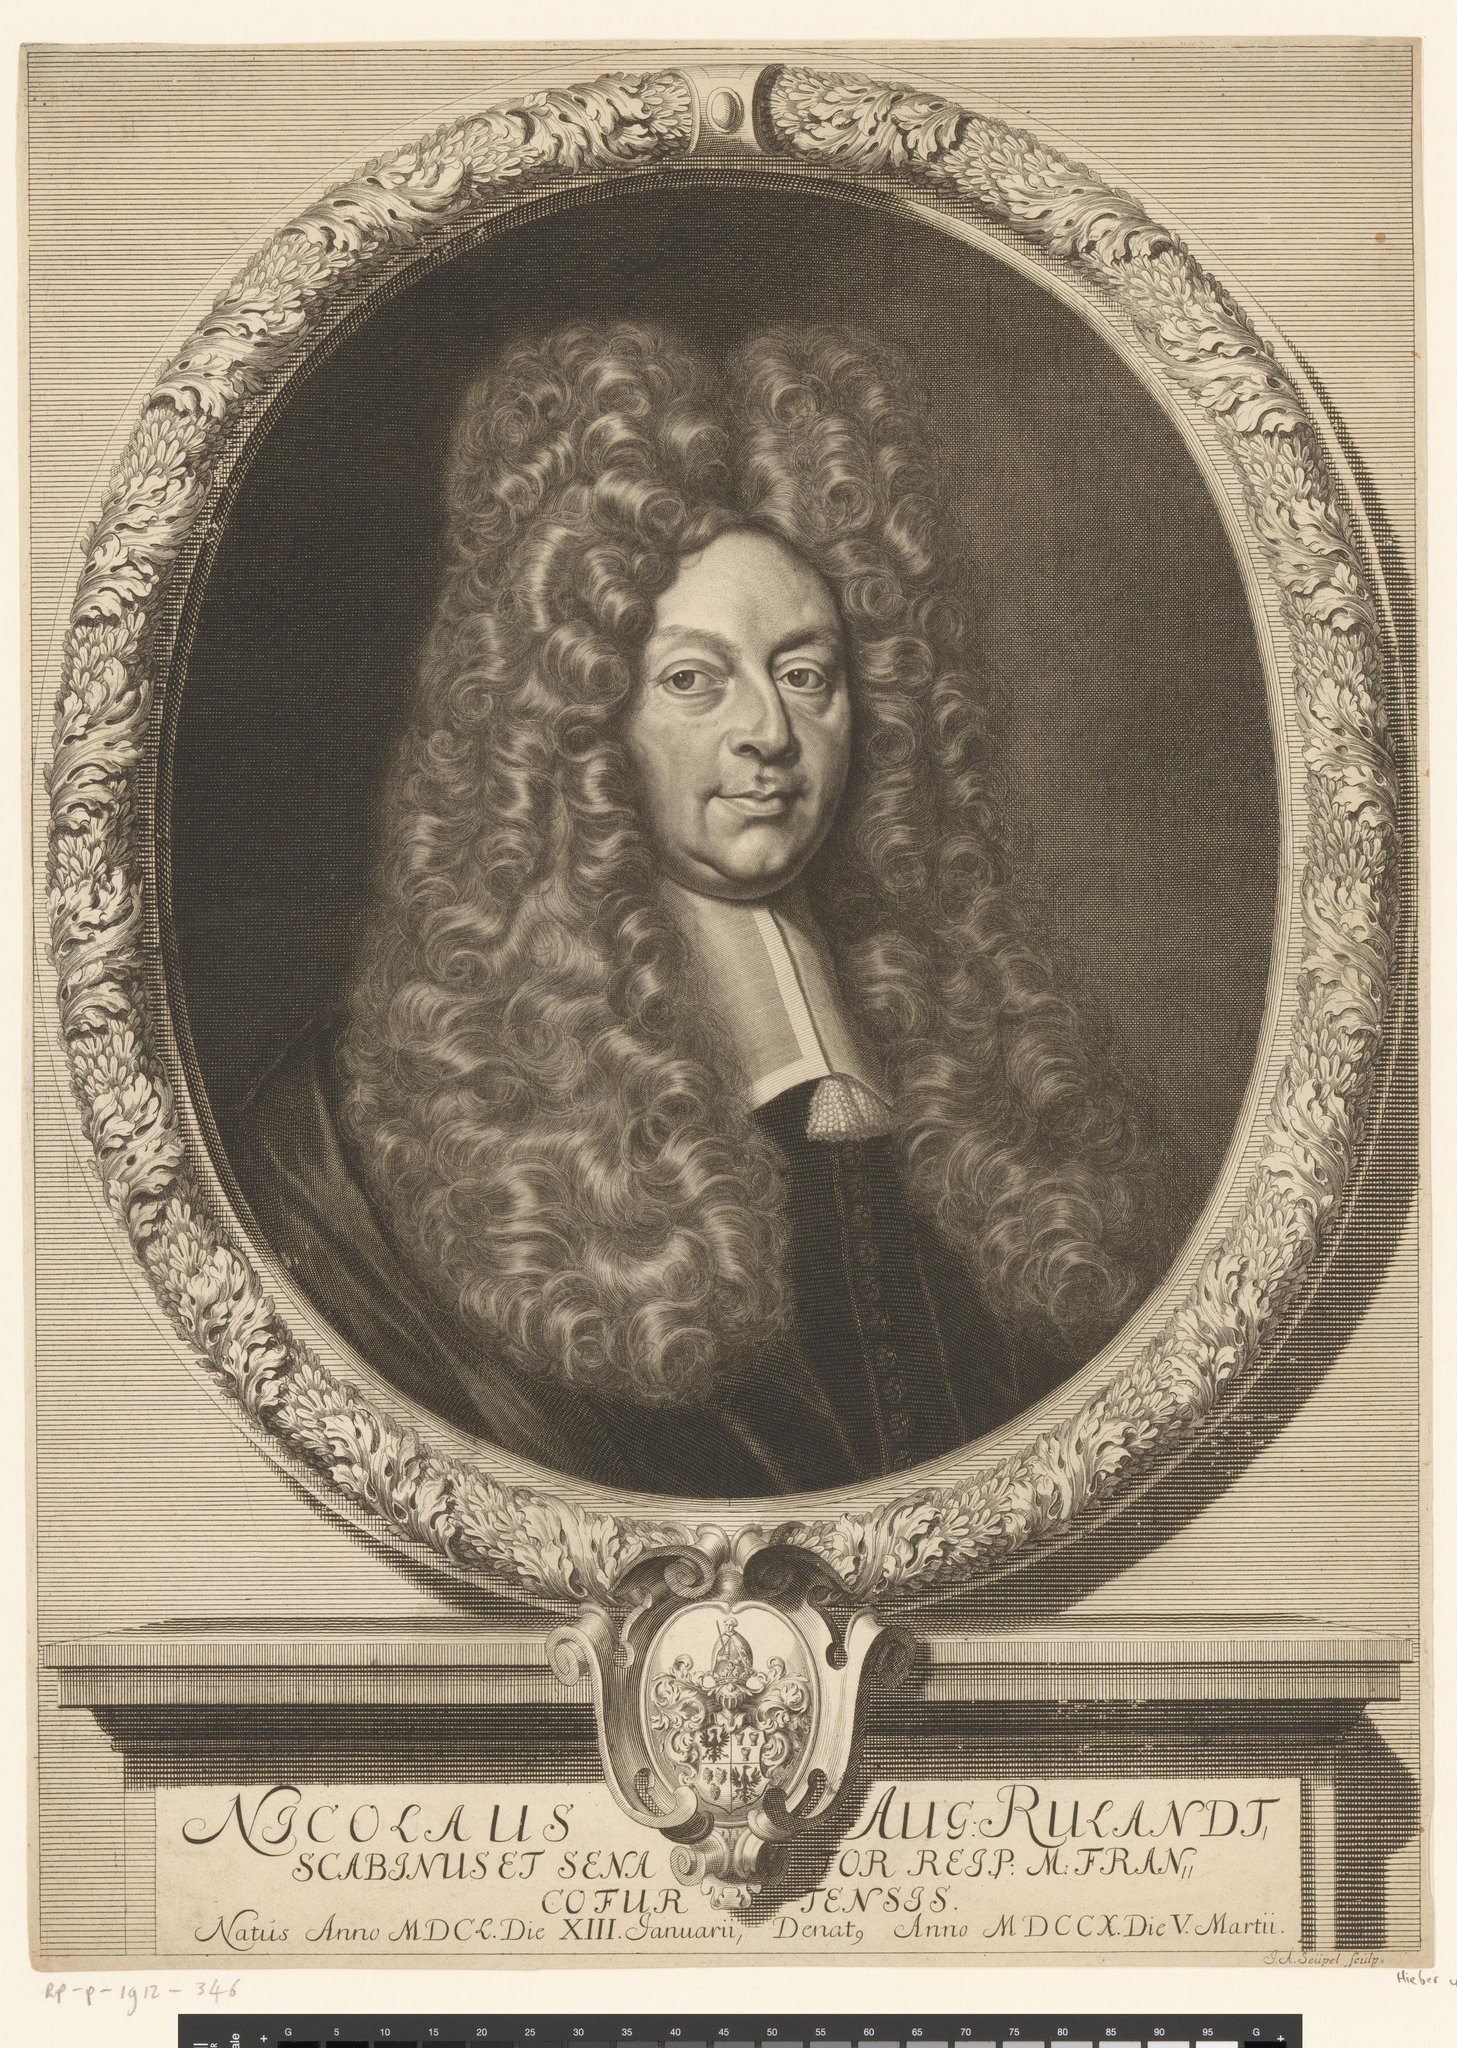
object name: print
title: Portret van Nicolaus August Rulandt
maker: johann adam seupel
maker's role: painter, print maker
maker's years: 1662-1717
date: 1710-1717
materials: paper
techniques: engraving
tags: nicolaus august rulandt, historical persons, armorial bearing, heraldry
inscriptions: collector's mark: Lugt 2228